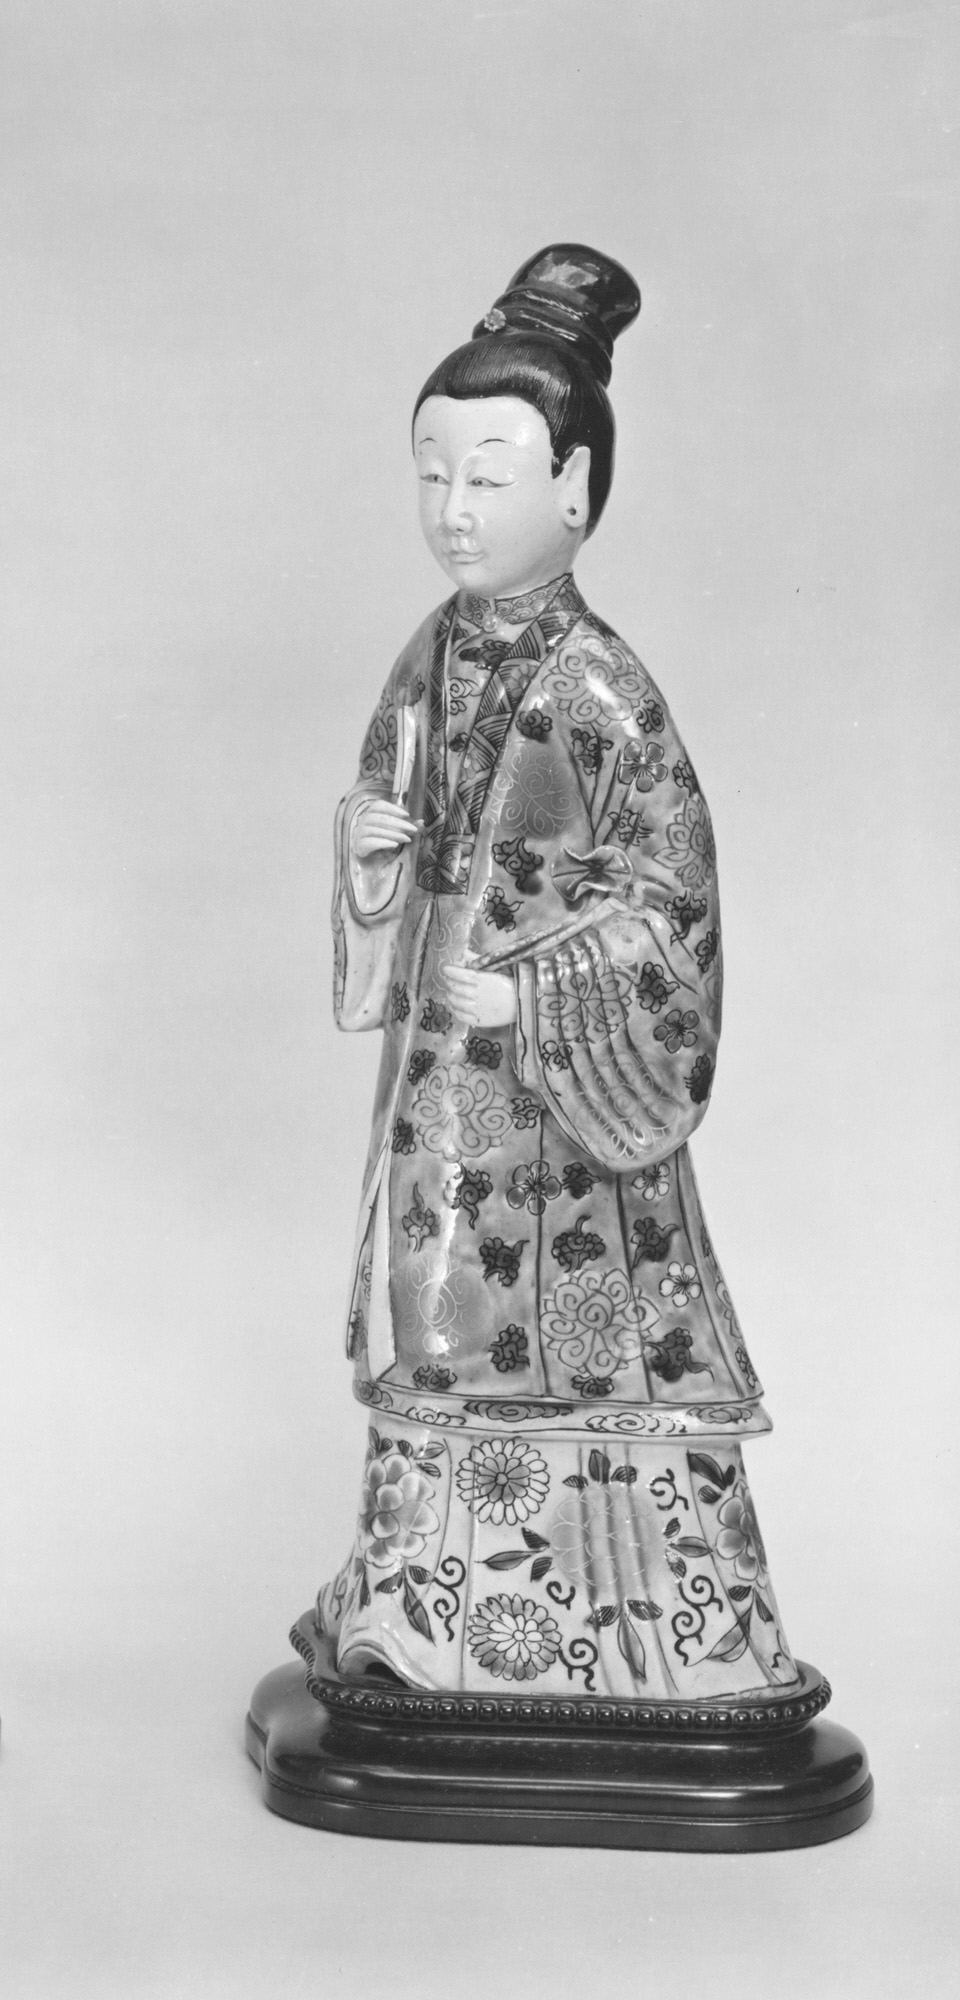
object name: figure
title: Female figure (one of a pair)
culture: chinese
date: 1667-1733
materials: biscuit, enamel, glaze, porcelain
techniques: painting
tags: women